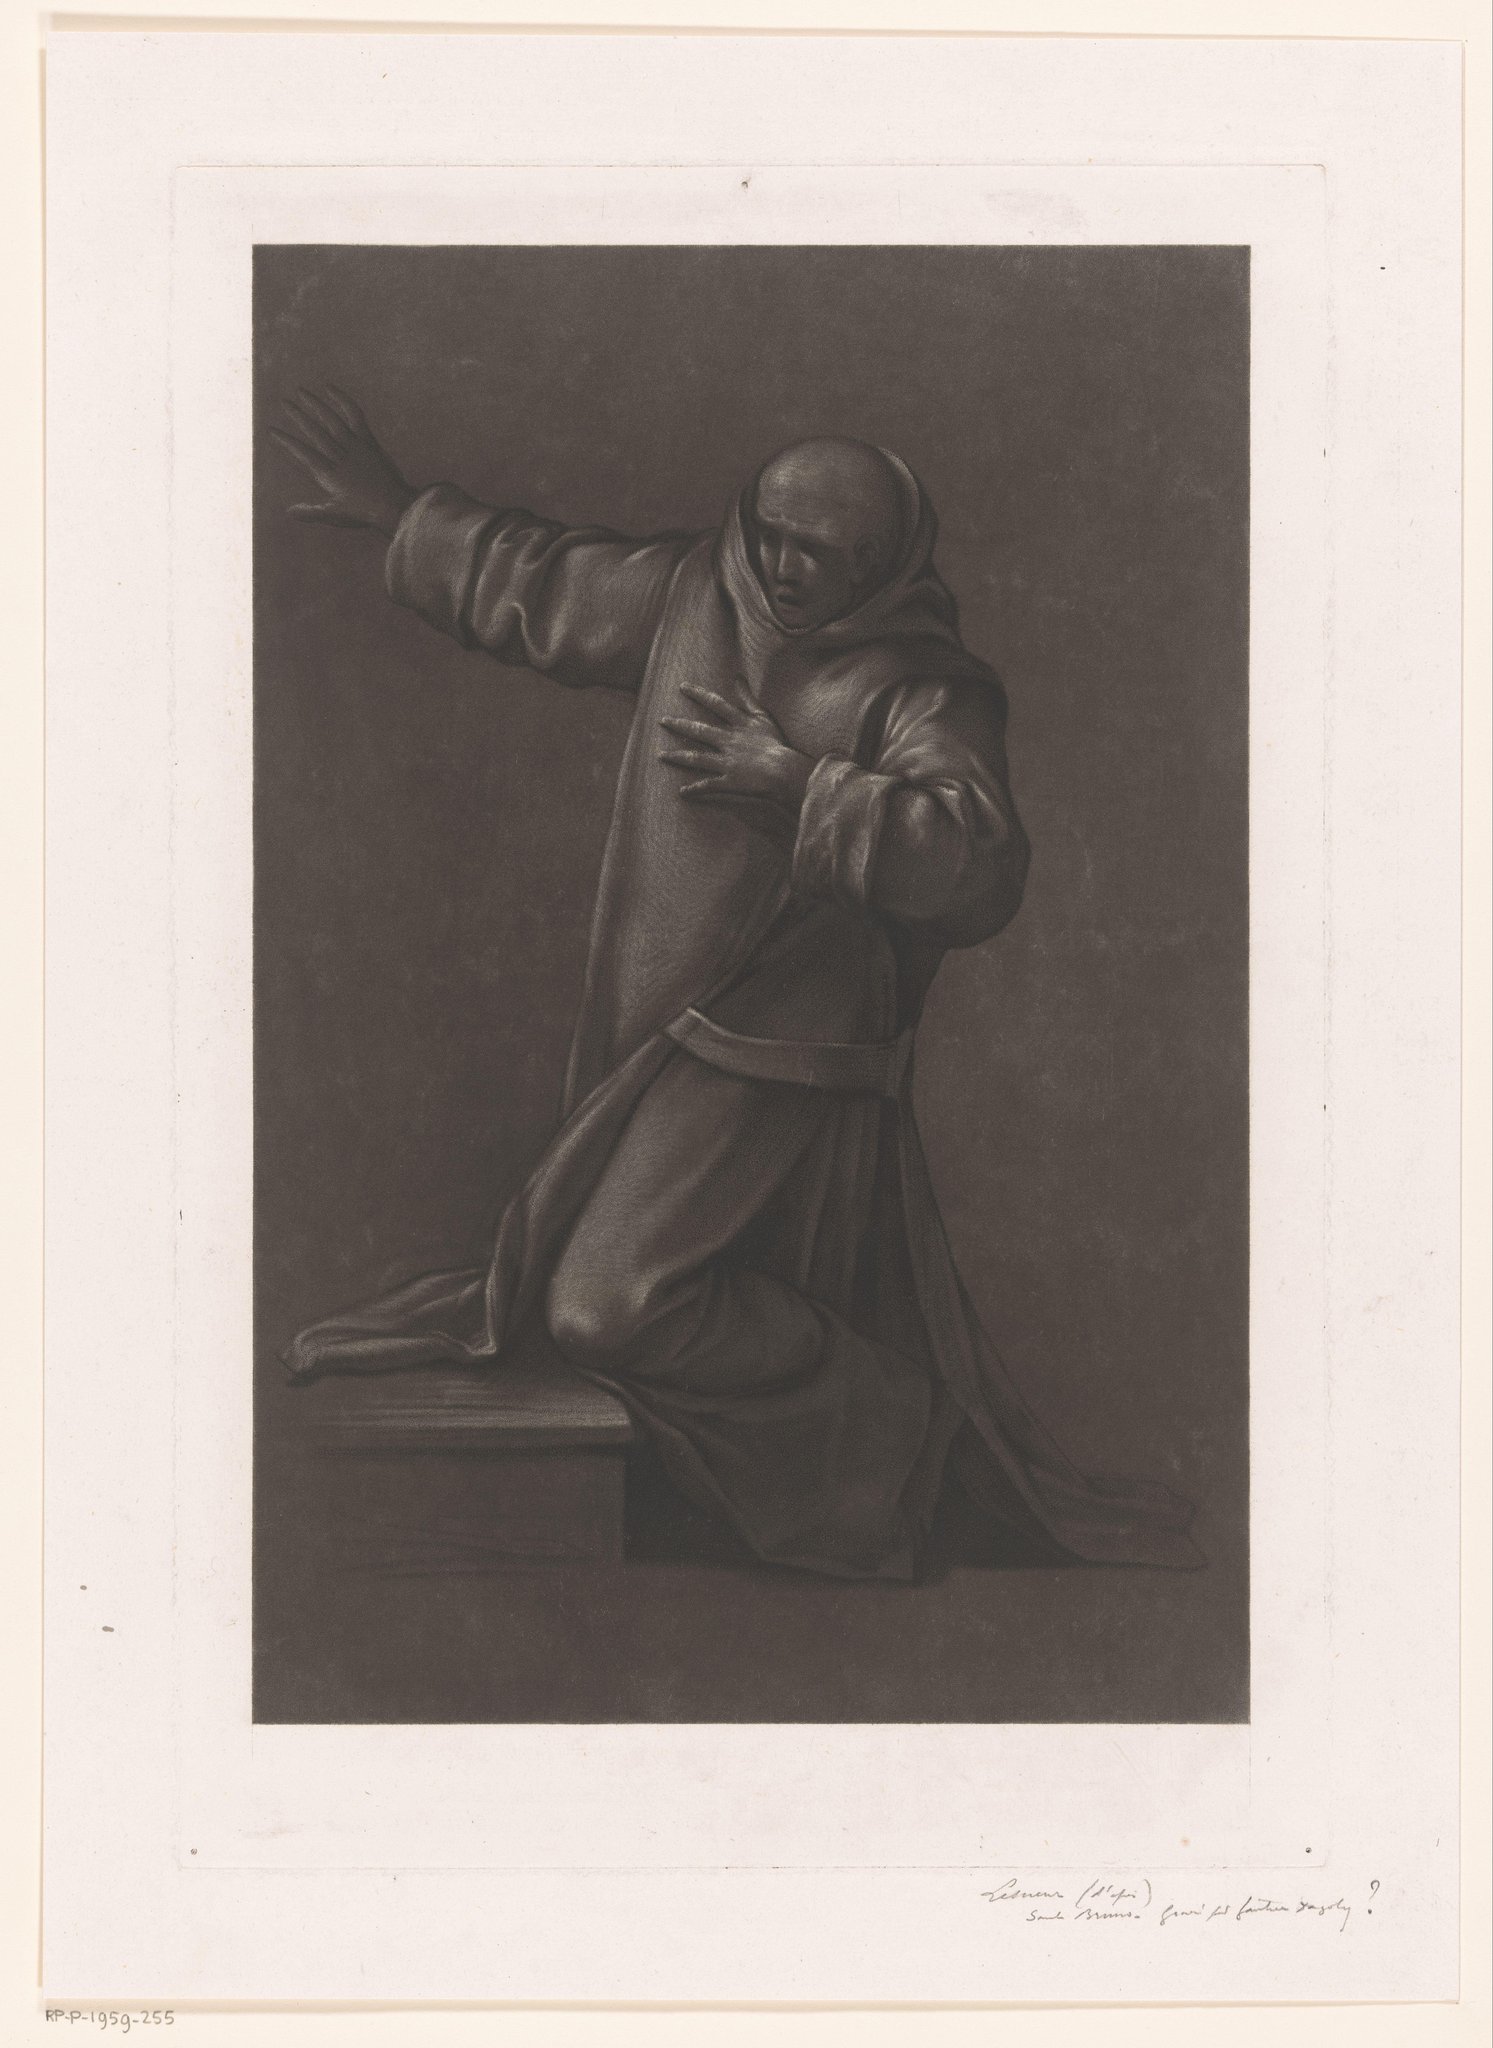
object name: print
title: Heilige Bruno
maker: edouard gautier dagoty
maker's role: print maker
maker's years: 1744-1783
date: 1754-1784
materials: paper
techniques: mezzotint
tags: the founder of the order of the carthusians, bruno; possible attributes: cross, finger at lips, lily, mitre at his feet, olive-branch, ray of light, skull, (seven) star(s)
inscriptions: collector's mark: Lugt 2228, collector's mark: Lugt 2760